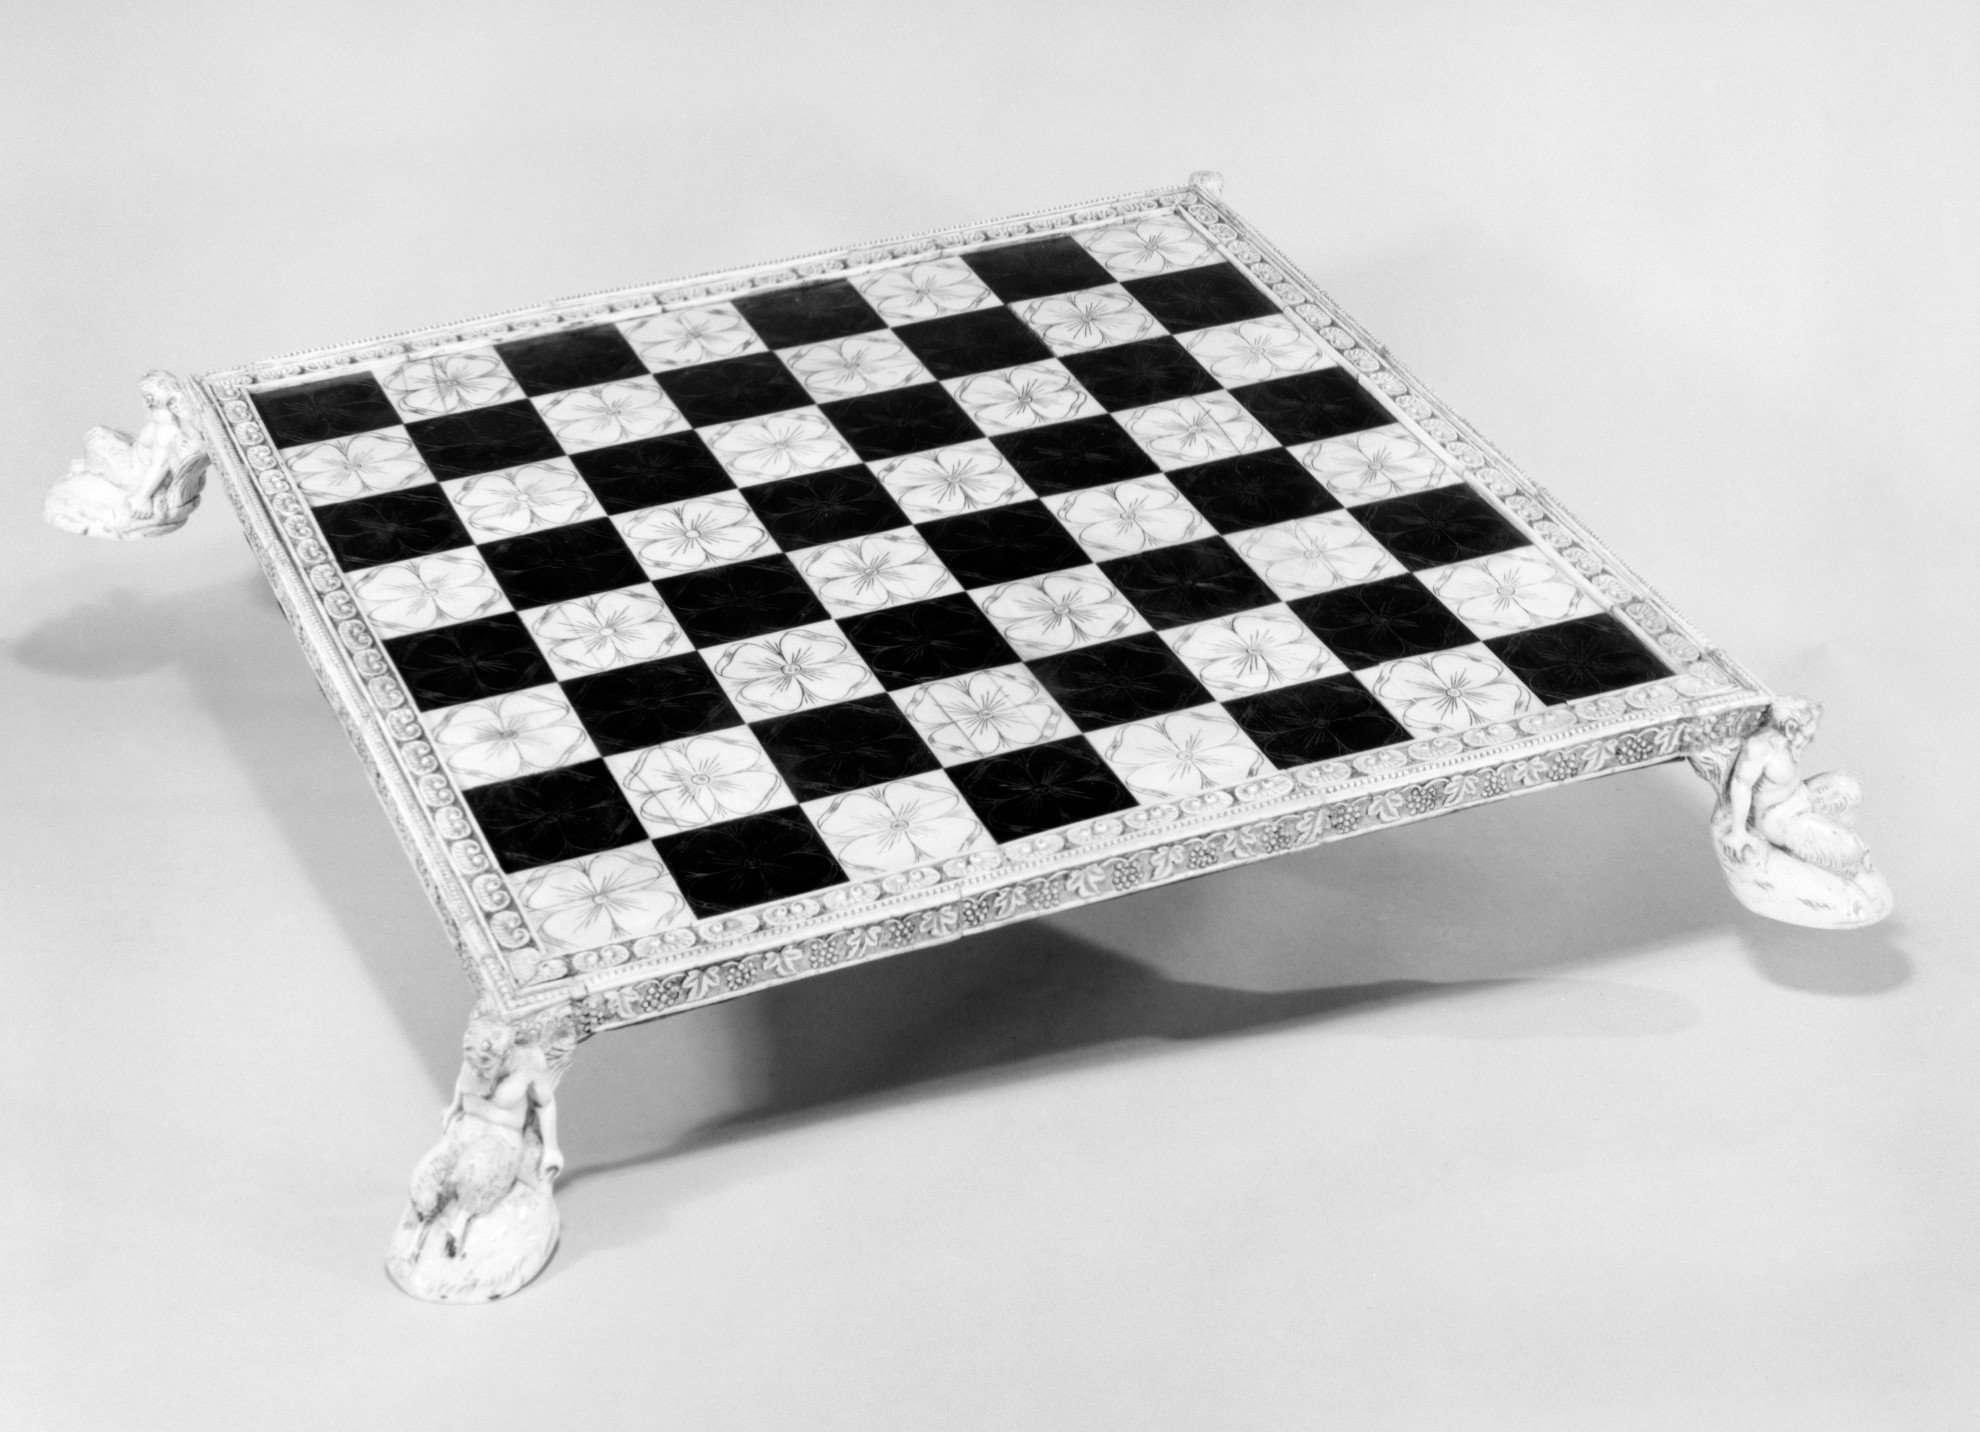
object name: chessboard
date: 1801-1900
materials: ivory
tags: chess,fauns,games